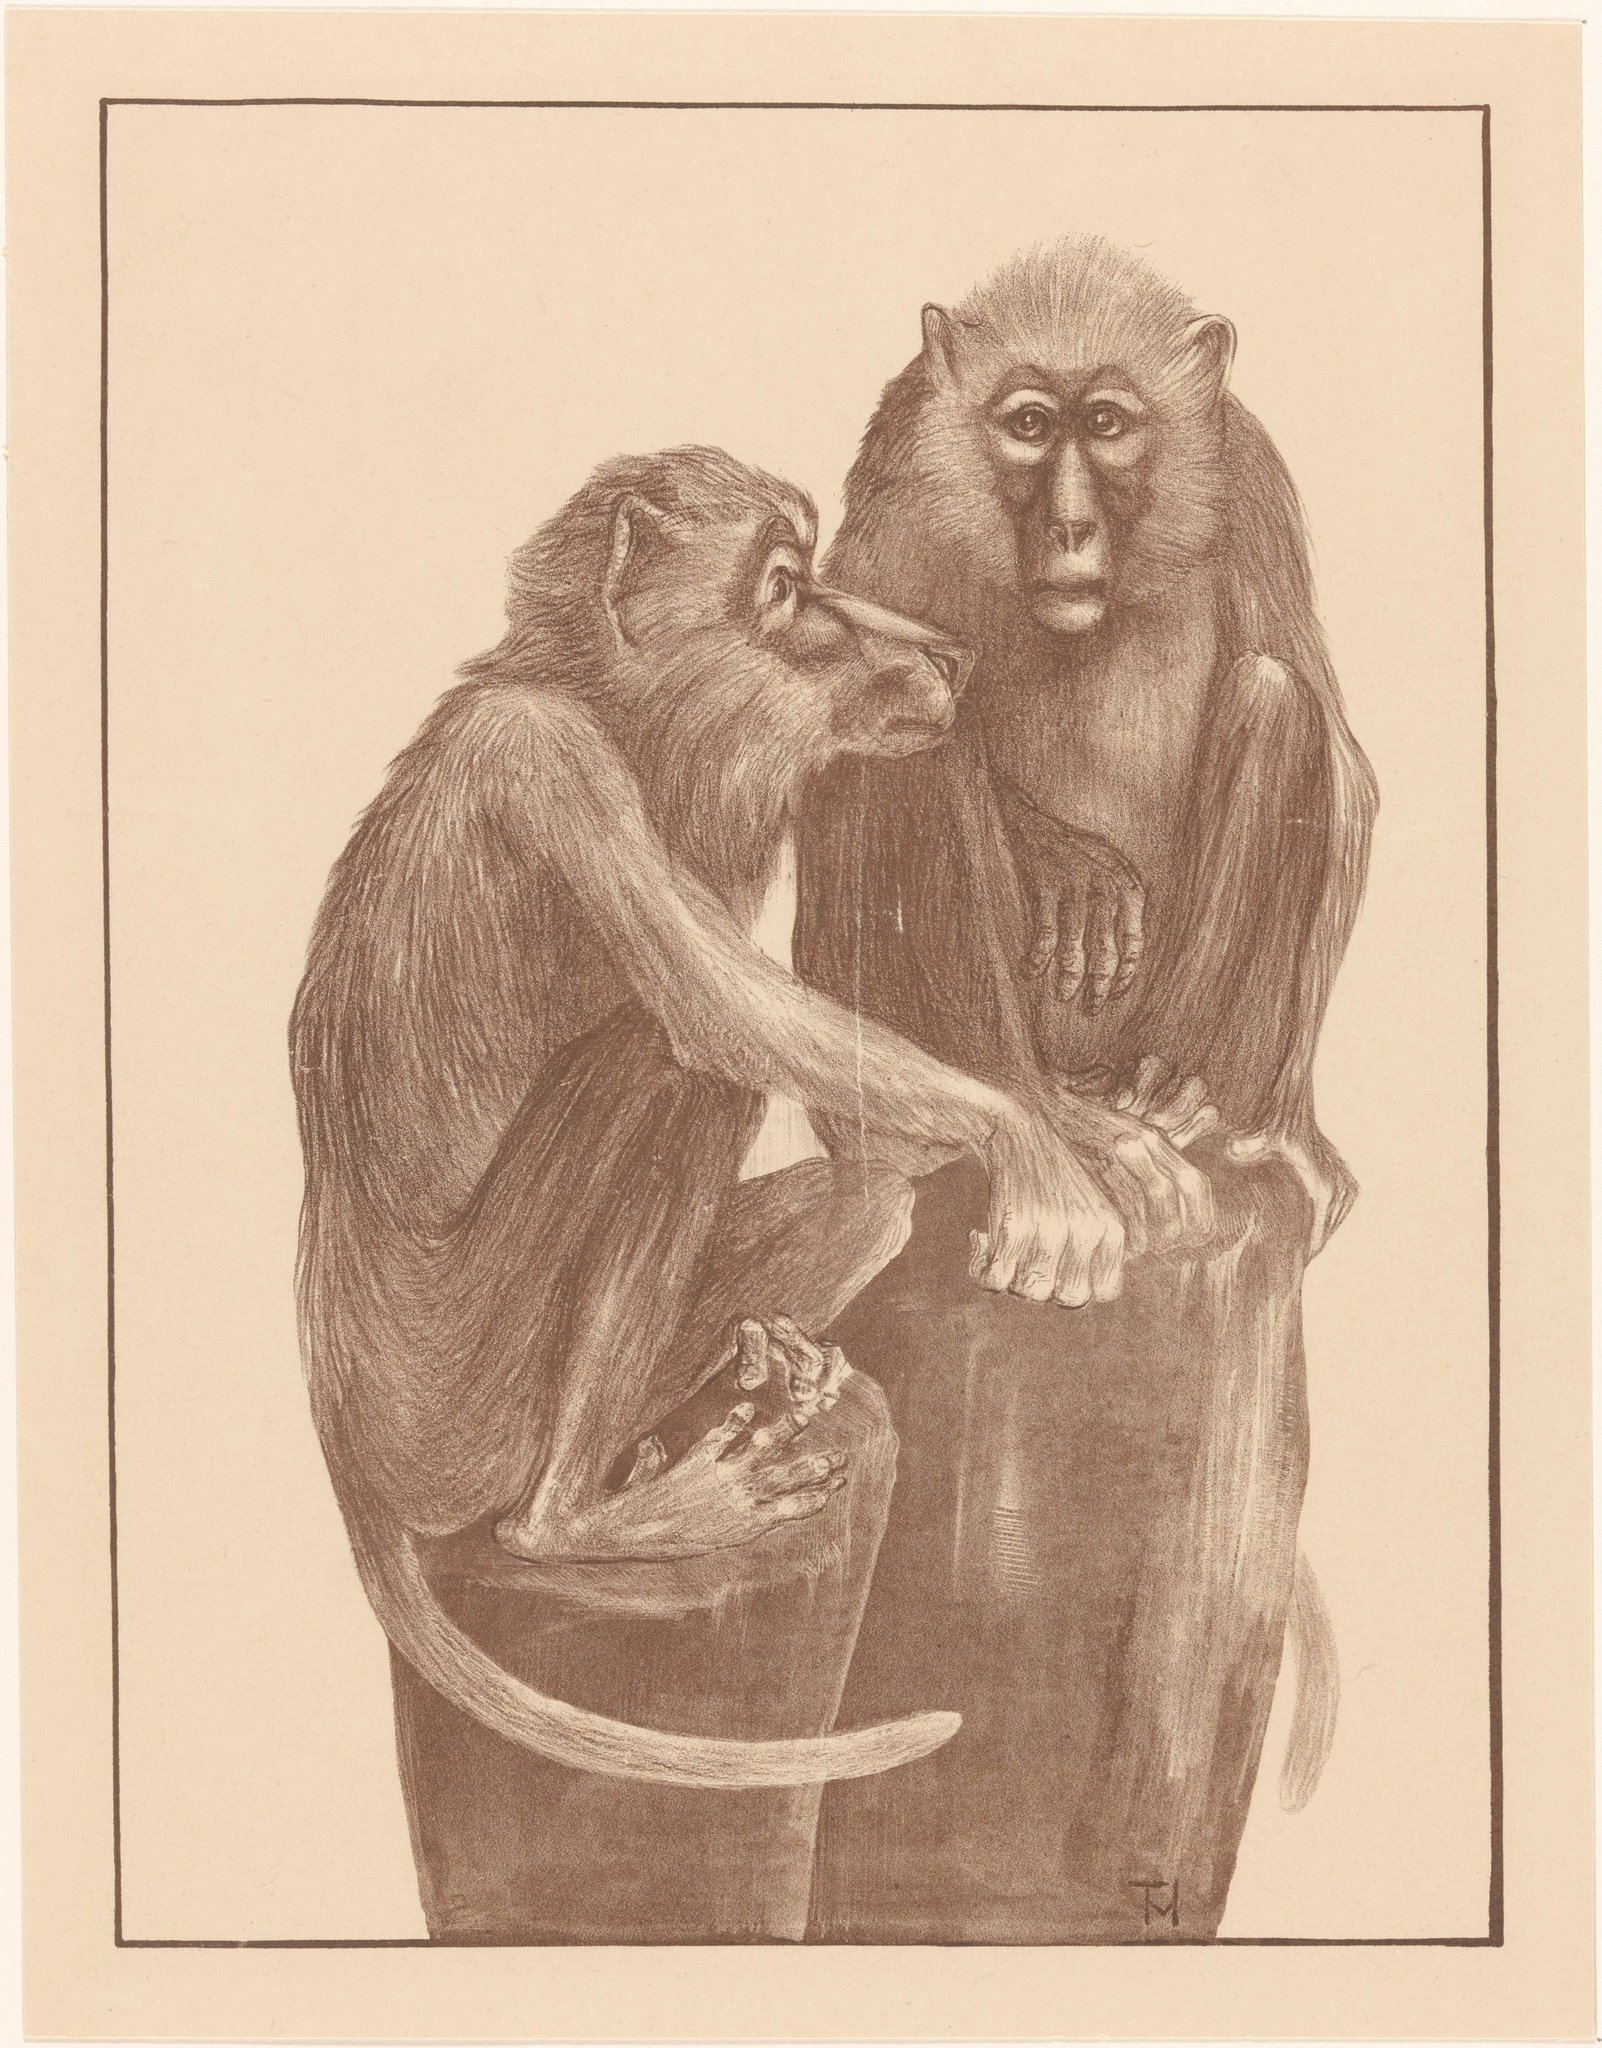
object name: print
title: Dierstudies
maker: theo van hoytema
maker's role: draughtsman, painter, print maker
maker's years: 1863-1917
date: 1878-1914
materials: paper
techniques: lithograph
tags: monkeys, apes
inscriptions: collector's mark: Lugt 2233